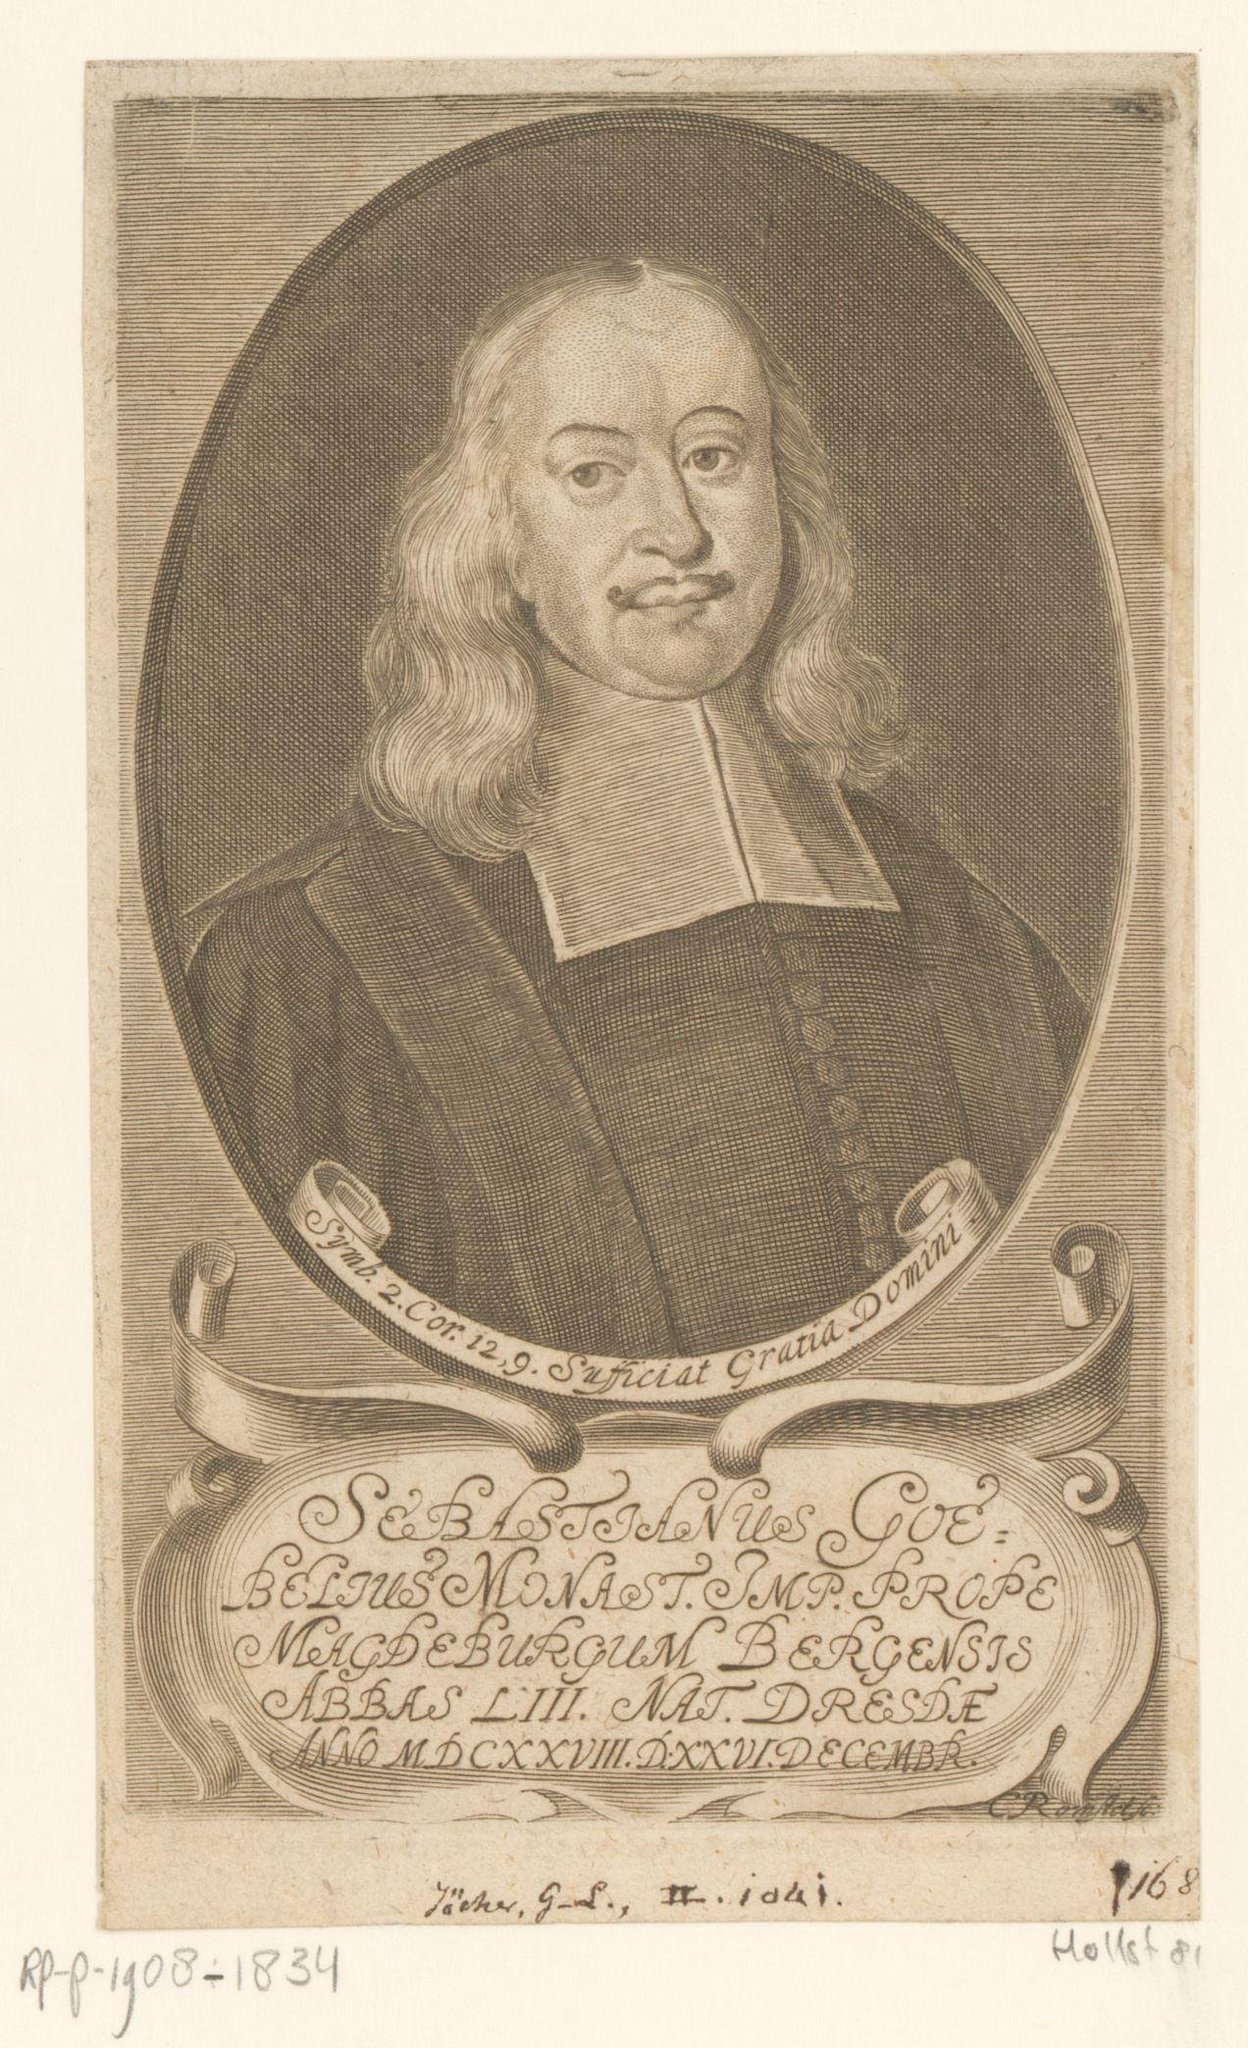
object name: print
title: Portret van Sebastian Göbel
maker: christian romstet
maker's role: print maker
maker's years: 1640-1721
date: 1665-1721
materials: paper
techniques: engraving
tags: theologian, historical persons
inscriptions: collector's mark: Lugt 2228